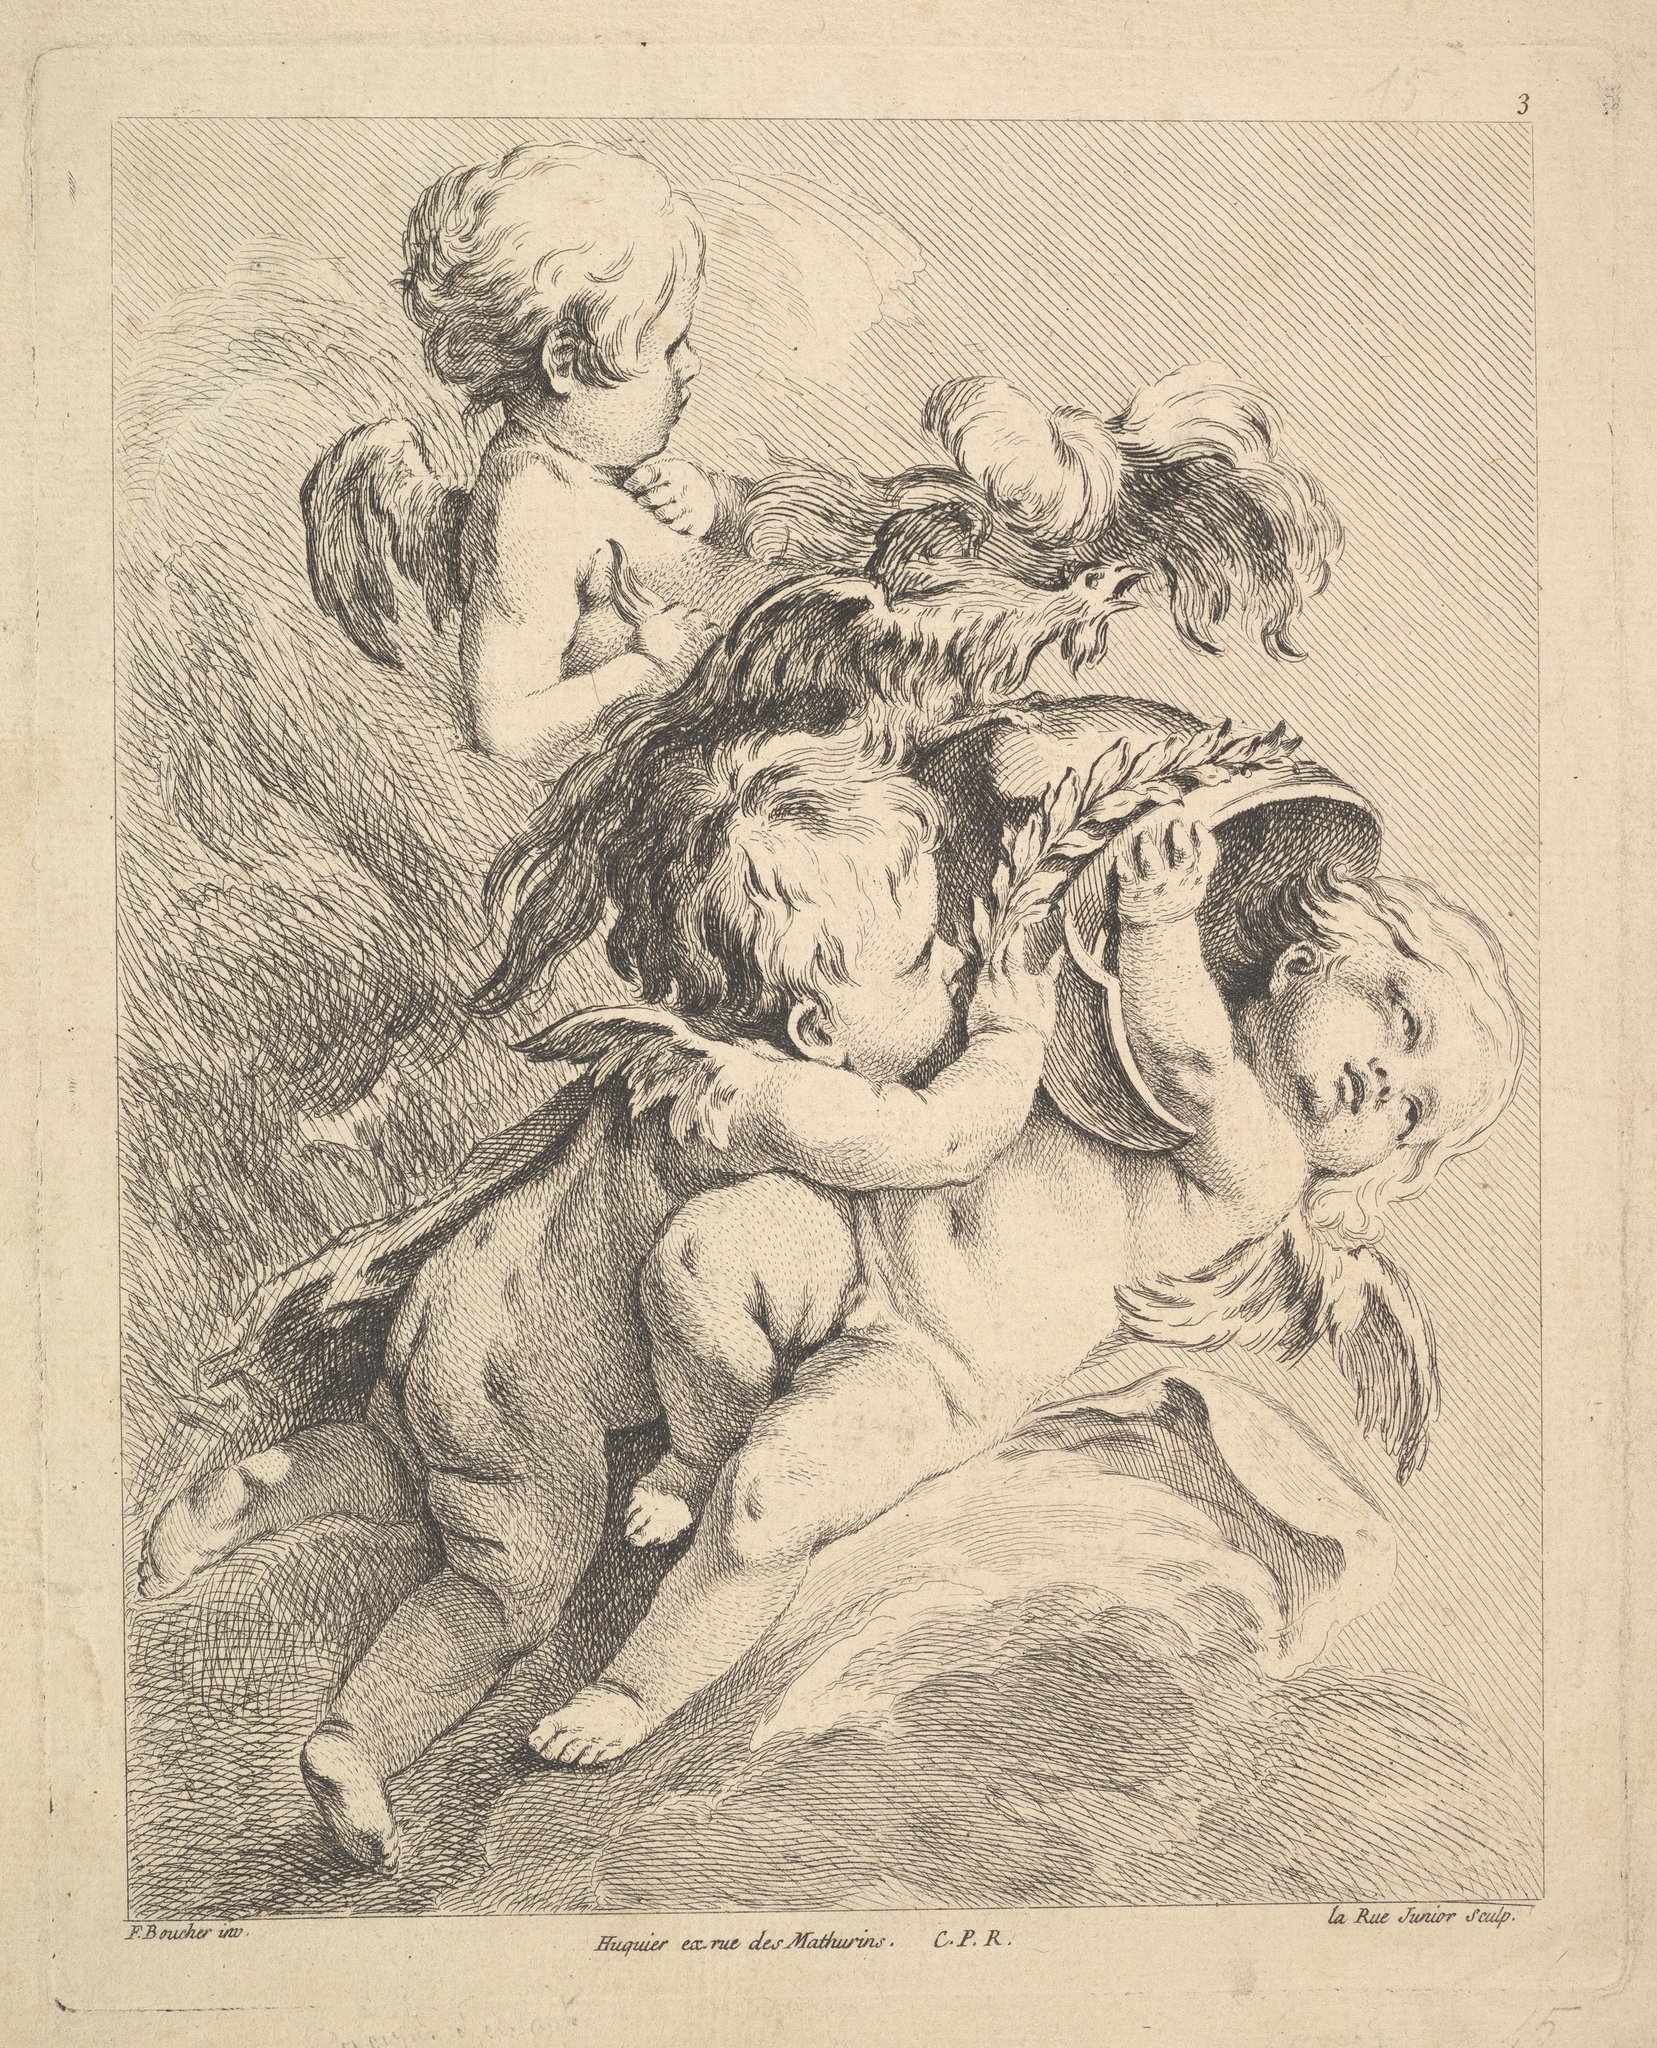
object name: print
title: Three Cupids Holding a Helmet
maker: louis félix de la rue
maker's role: artist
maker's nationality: french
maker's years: 1731-1765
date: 1731-1765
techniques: engraving, etching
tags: helmets,cupid